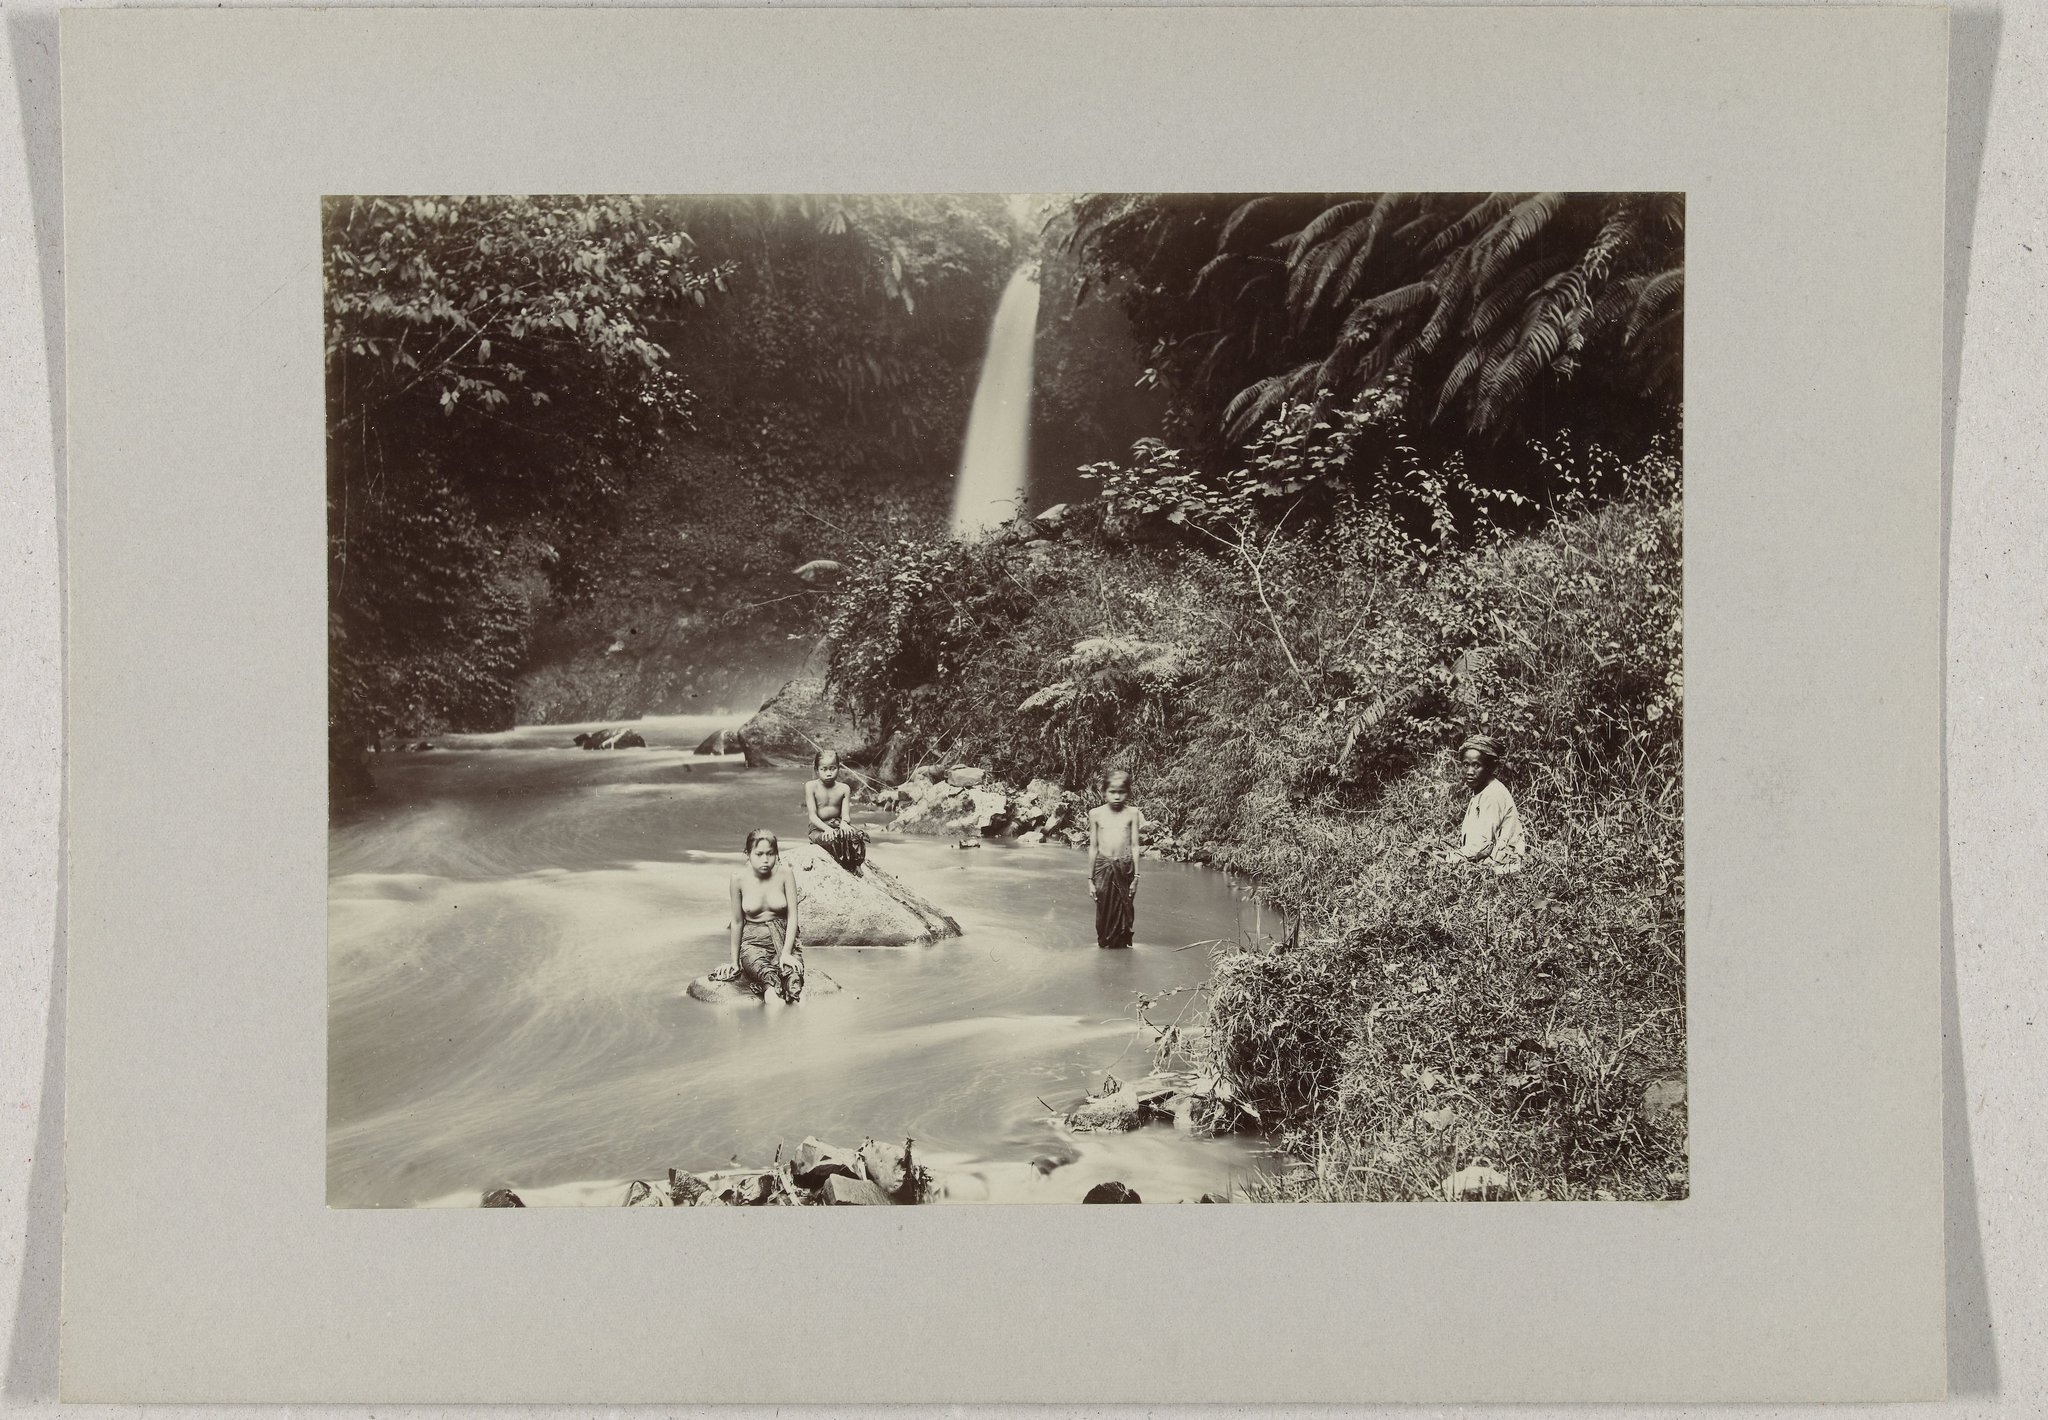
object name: photograph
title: Tjoeroekwaterval te Bandung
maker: Anonymous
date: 1895-1915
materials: cardboard, paper, photographic support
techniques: gelatin silver print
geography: dutch east indies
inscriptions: annotation: ‘60. Tjoeroekwaterval te Bandong’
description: Tjoeroekwaterval te Bandoeng, Nederlands-Indië